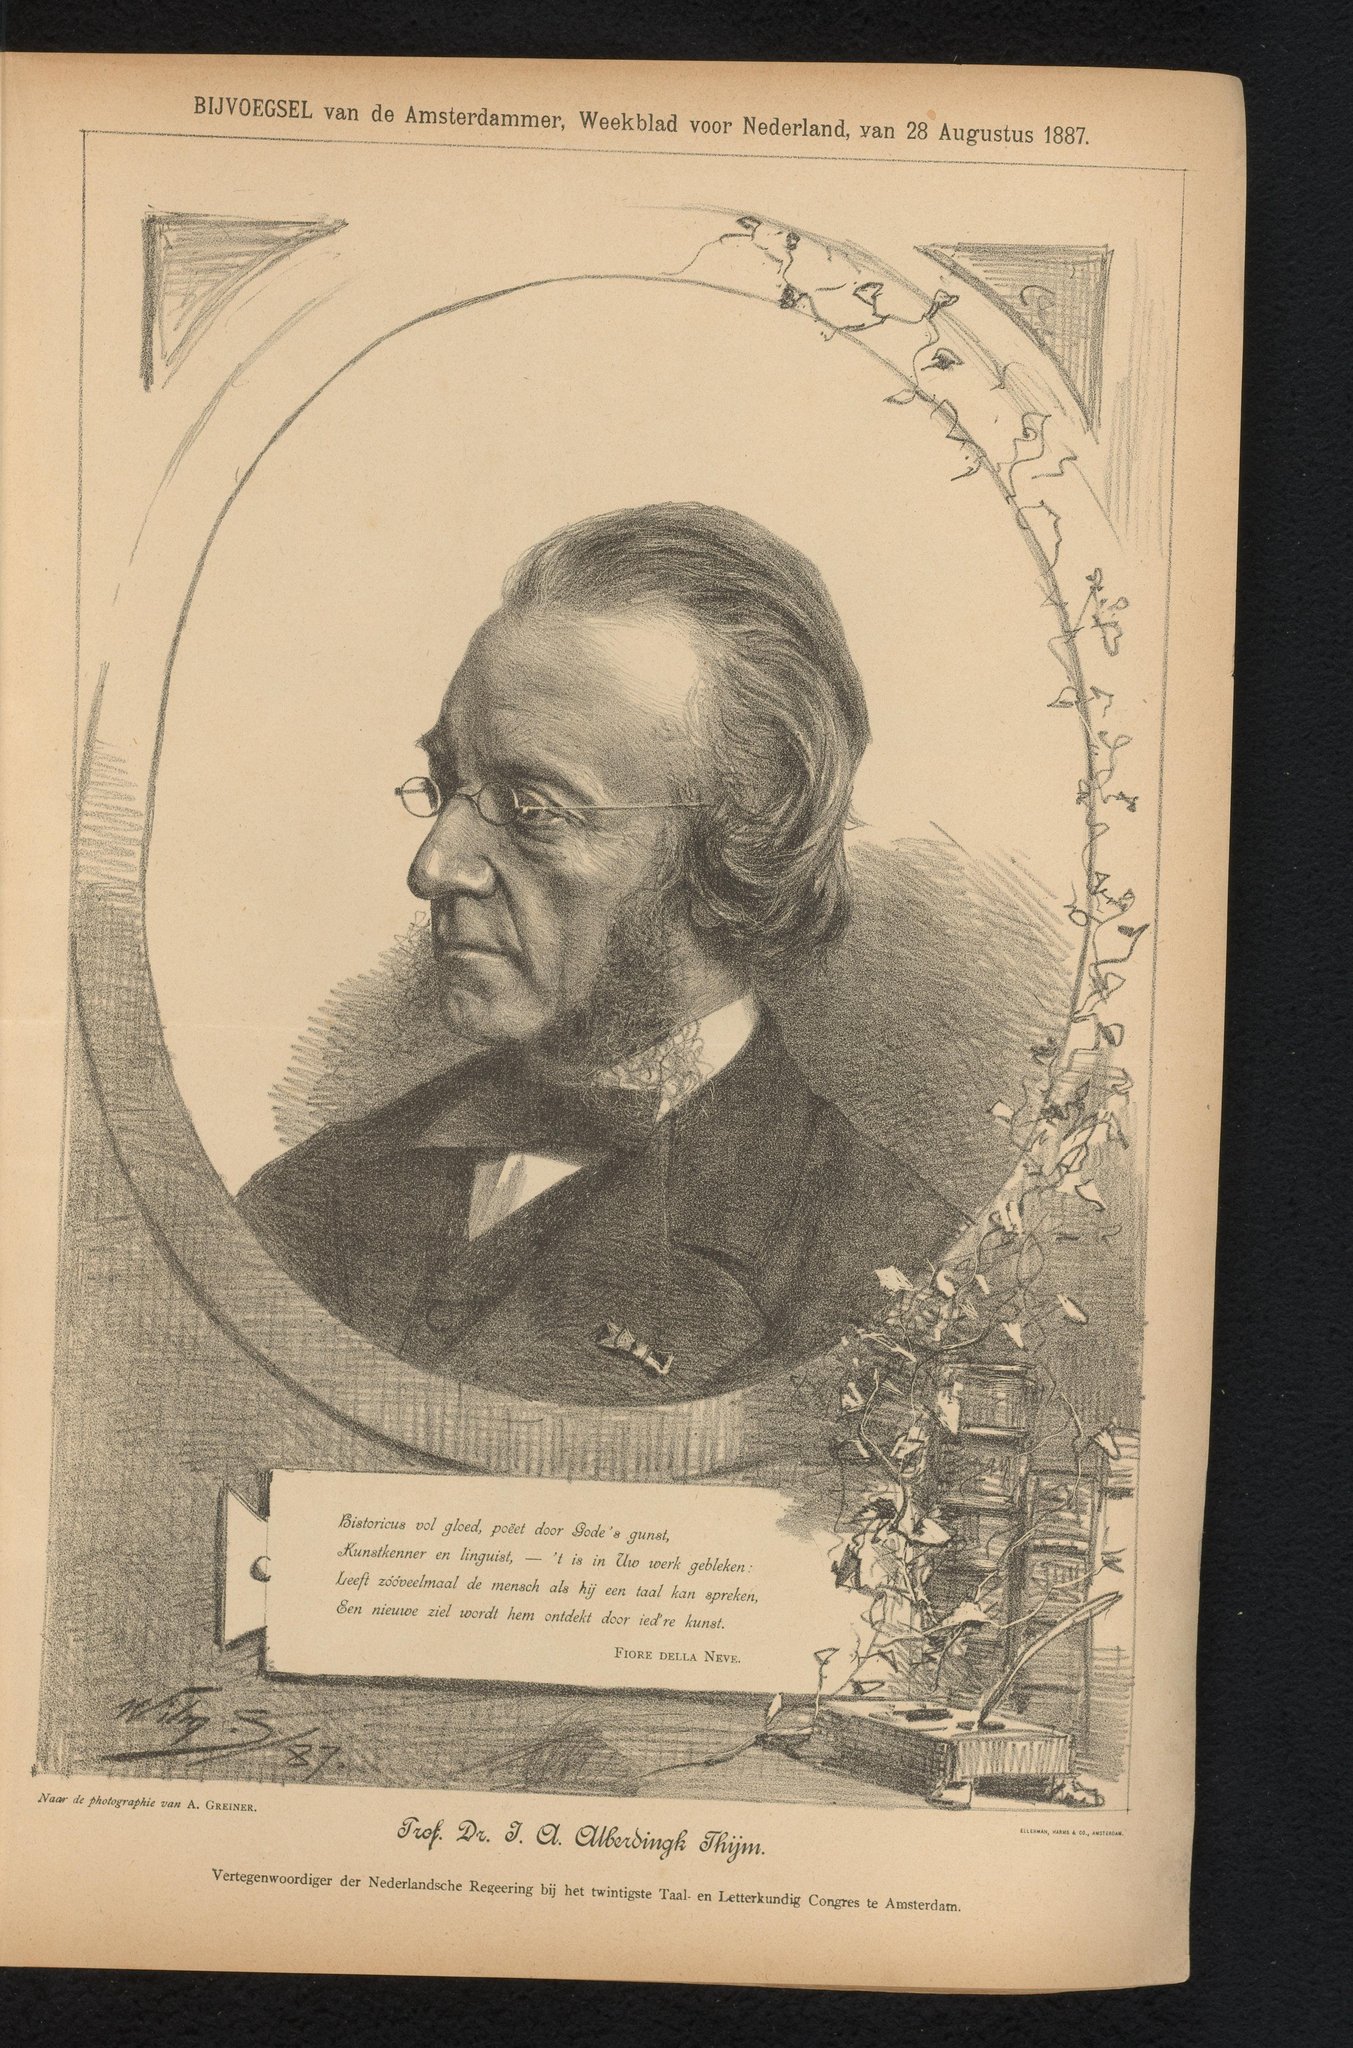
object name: print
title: Prof. Dr. J.A. Alberdingk Thijm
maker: willem steelink (ii)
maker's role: draughtsman, print maker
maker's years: 1856-1928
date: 1887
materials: paper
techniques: lithograph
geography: amsterdam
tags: amsterdam, painter, draughtsman, publisher, josephus albertus alberdingk thijm, historical persons, professor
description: Portret van professor Josephus Albertus Alberdingk Thijm, vertegenwoordiger van de Nederlandse regering op het twintigste Nederlandsche Taal- en Letterkundig Congres te Amsterdam, 15-17 september 1887.